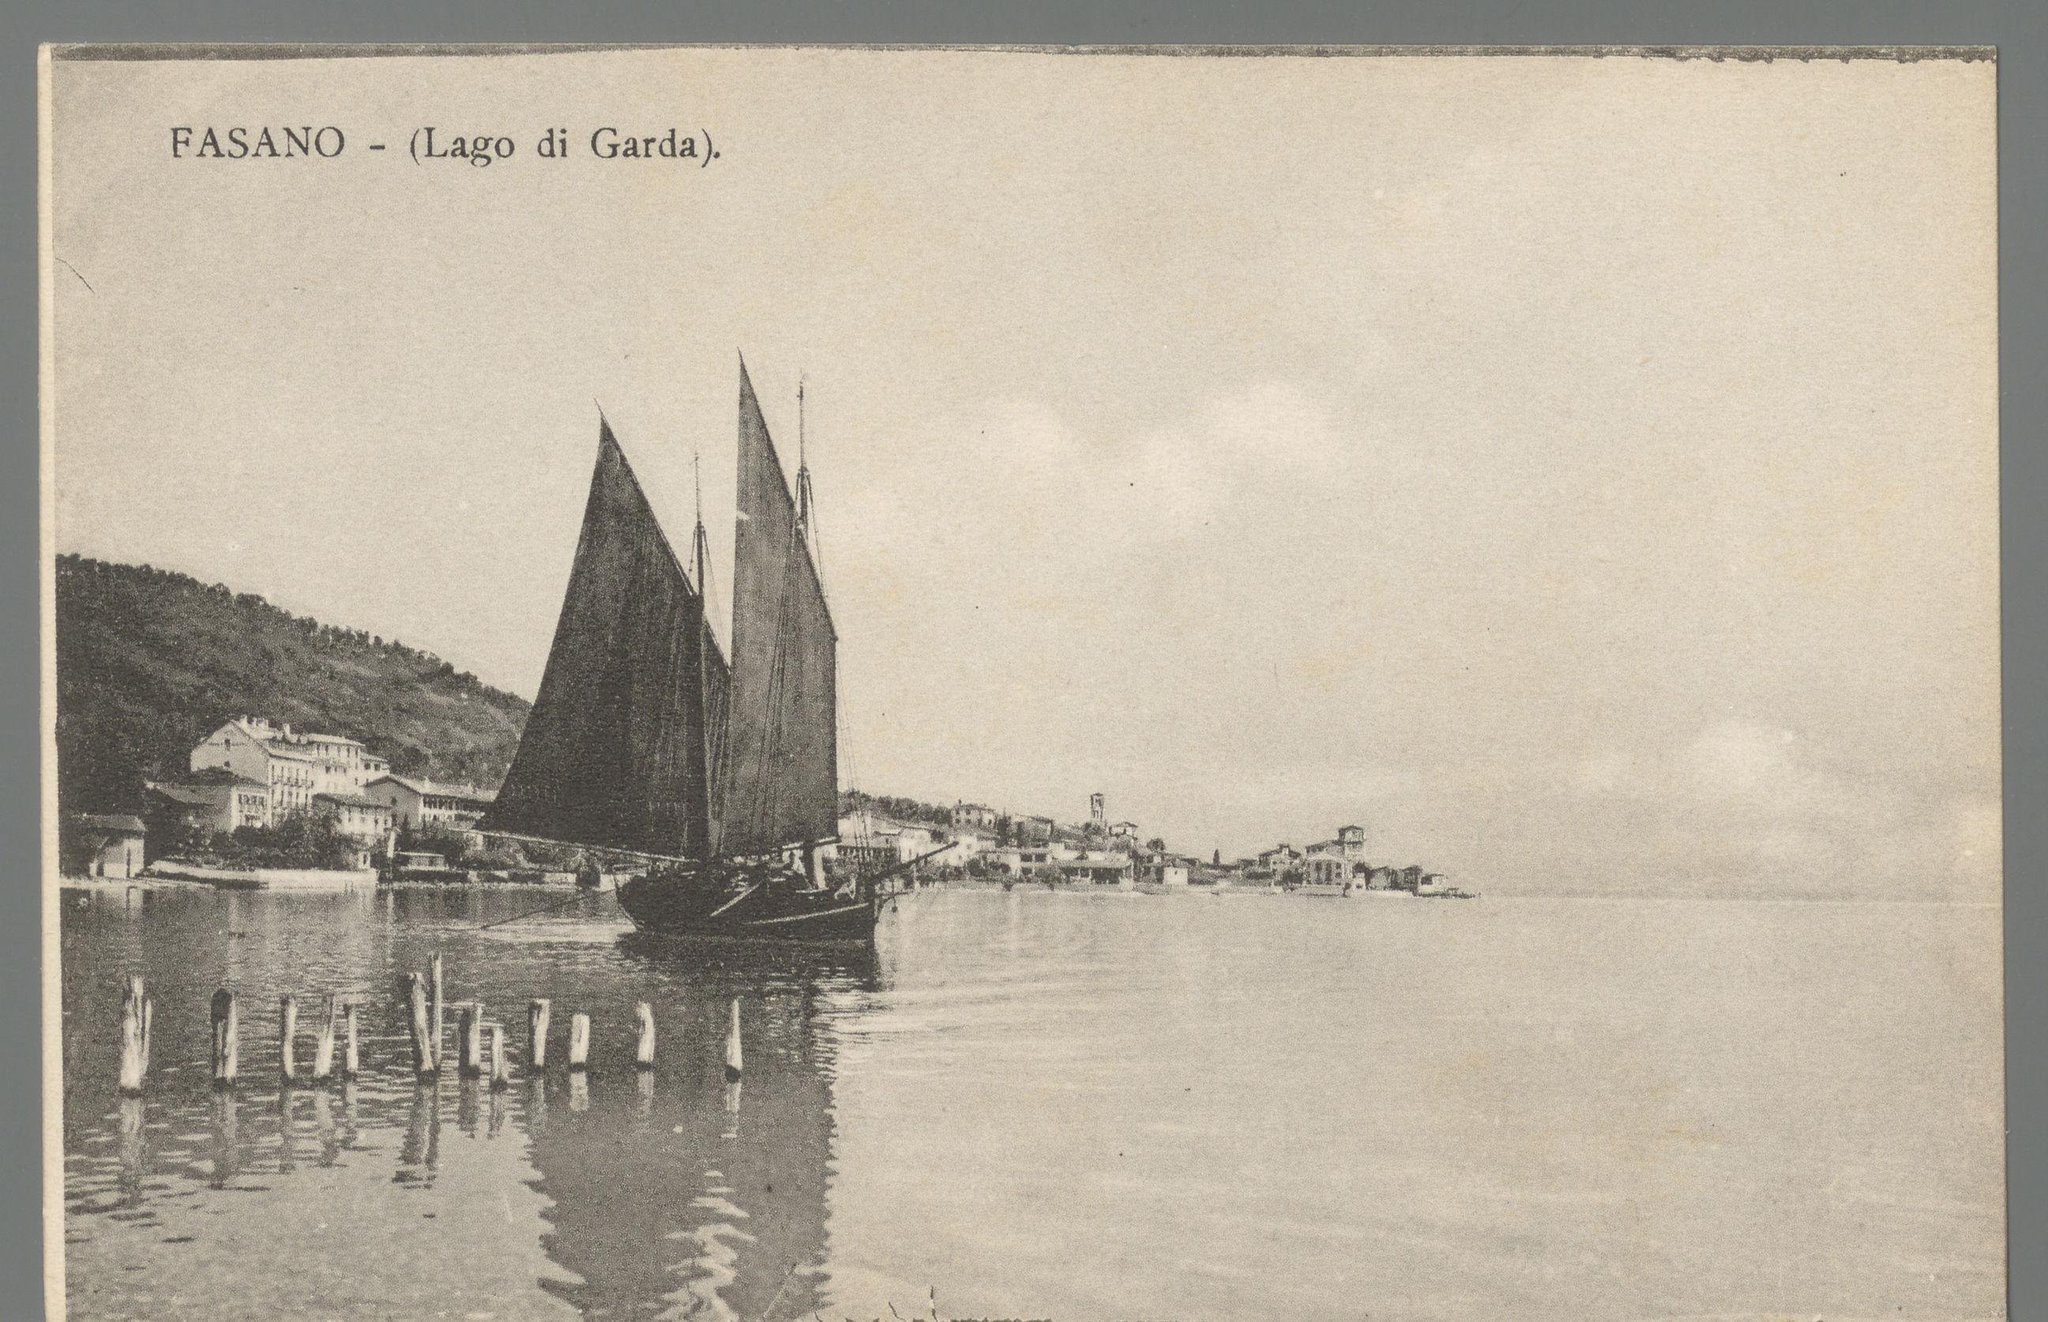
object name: ansichtkaart, prentbriefkaart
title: Fasano (Lago di Garda)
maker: Anonymous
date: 1906-1930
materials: cardboard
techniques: photograph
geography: gardone riviera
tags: prospect of village, silhouette of village, sailing-ship, sailing-boat, lake